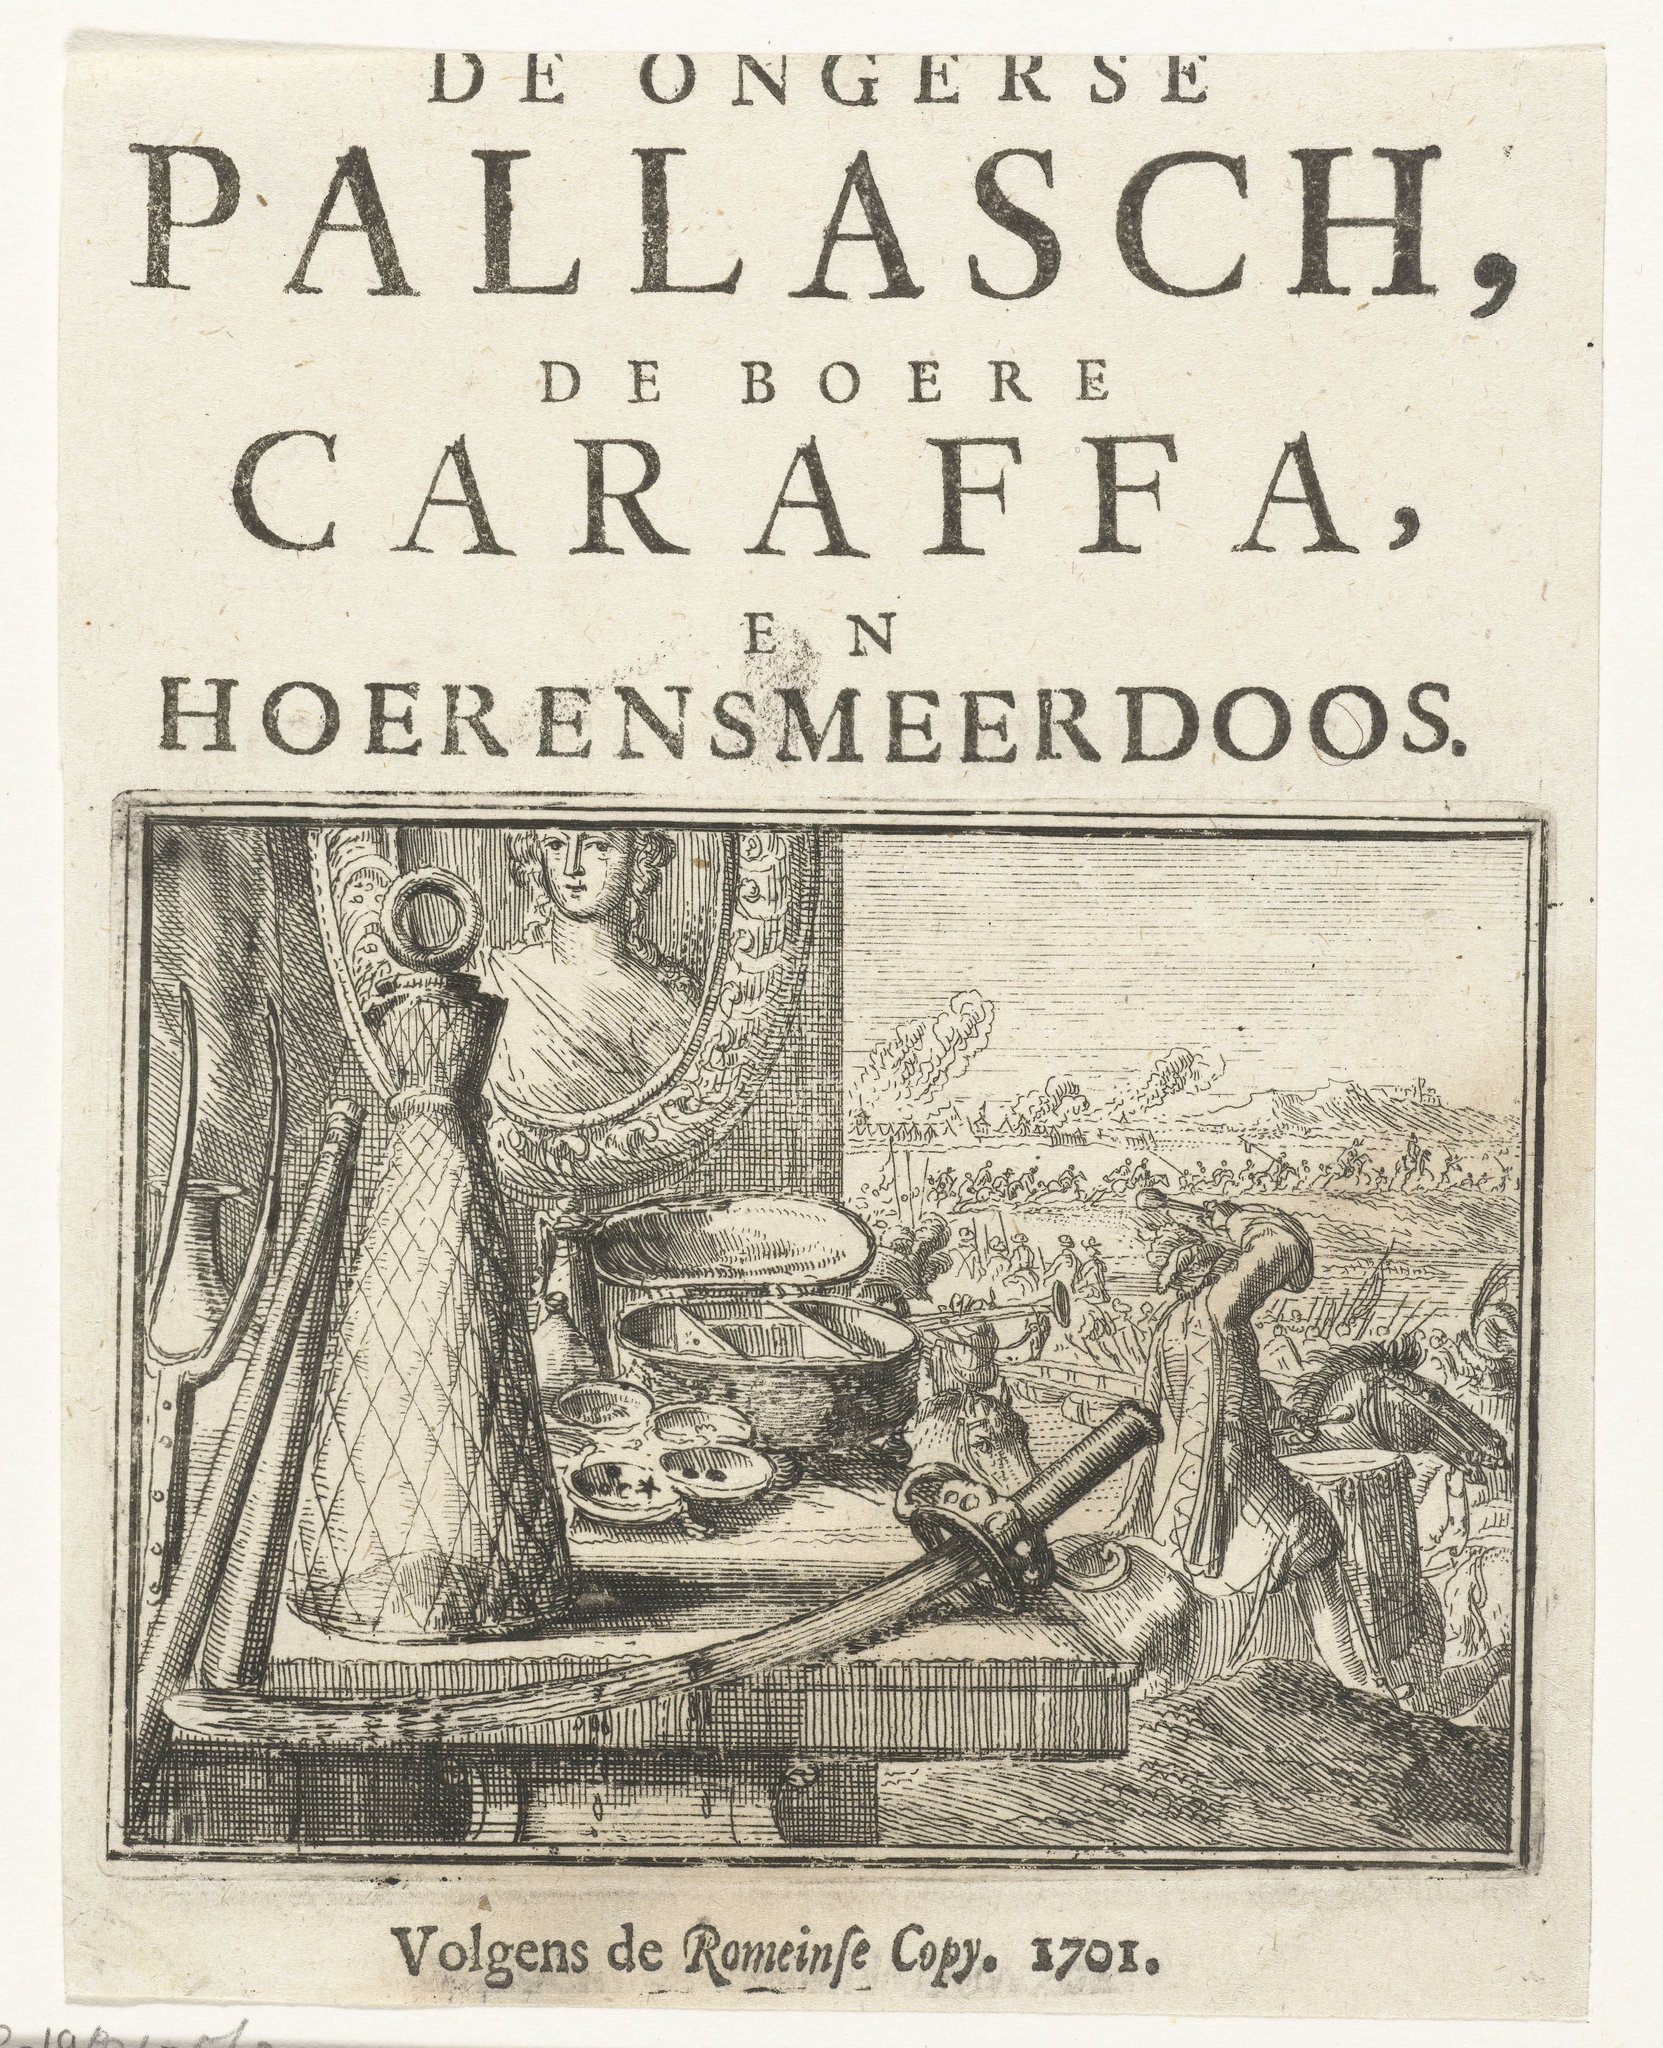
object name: print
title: Titelblad voor het pamflet: De Ongerse Pallasch, de Boere Caraffa, en Hoerensmeerdoos, 1701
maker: romeyn de hooghe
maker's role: draughtsman, goldsmith, painter, print maker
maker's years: 1645-1708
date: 1701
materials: paper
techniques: etching, letterpress printing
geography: northern netherlands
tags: making toilet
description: Titelblad voor het pamflet: De Ongerse Pallasch, de Boere Caraffa, en Hoerensmeerdoos, 1701. Tafel met een bloedig Hongaarse sabel, karaf en een toiletdoos, hierboven een vrouwenportret. Op de achtergrond een slagveld met Hongaarse troepen en vluchtende Fransen.